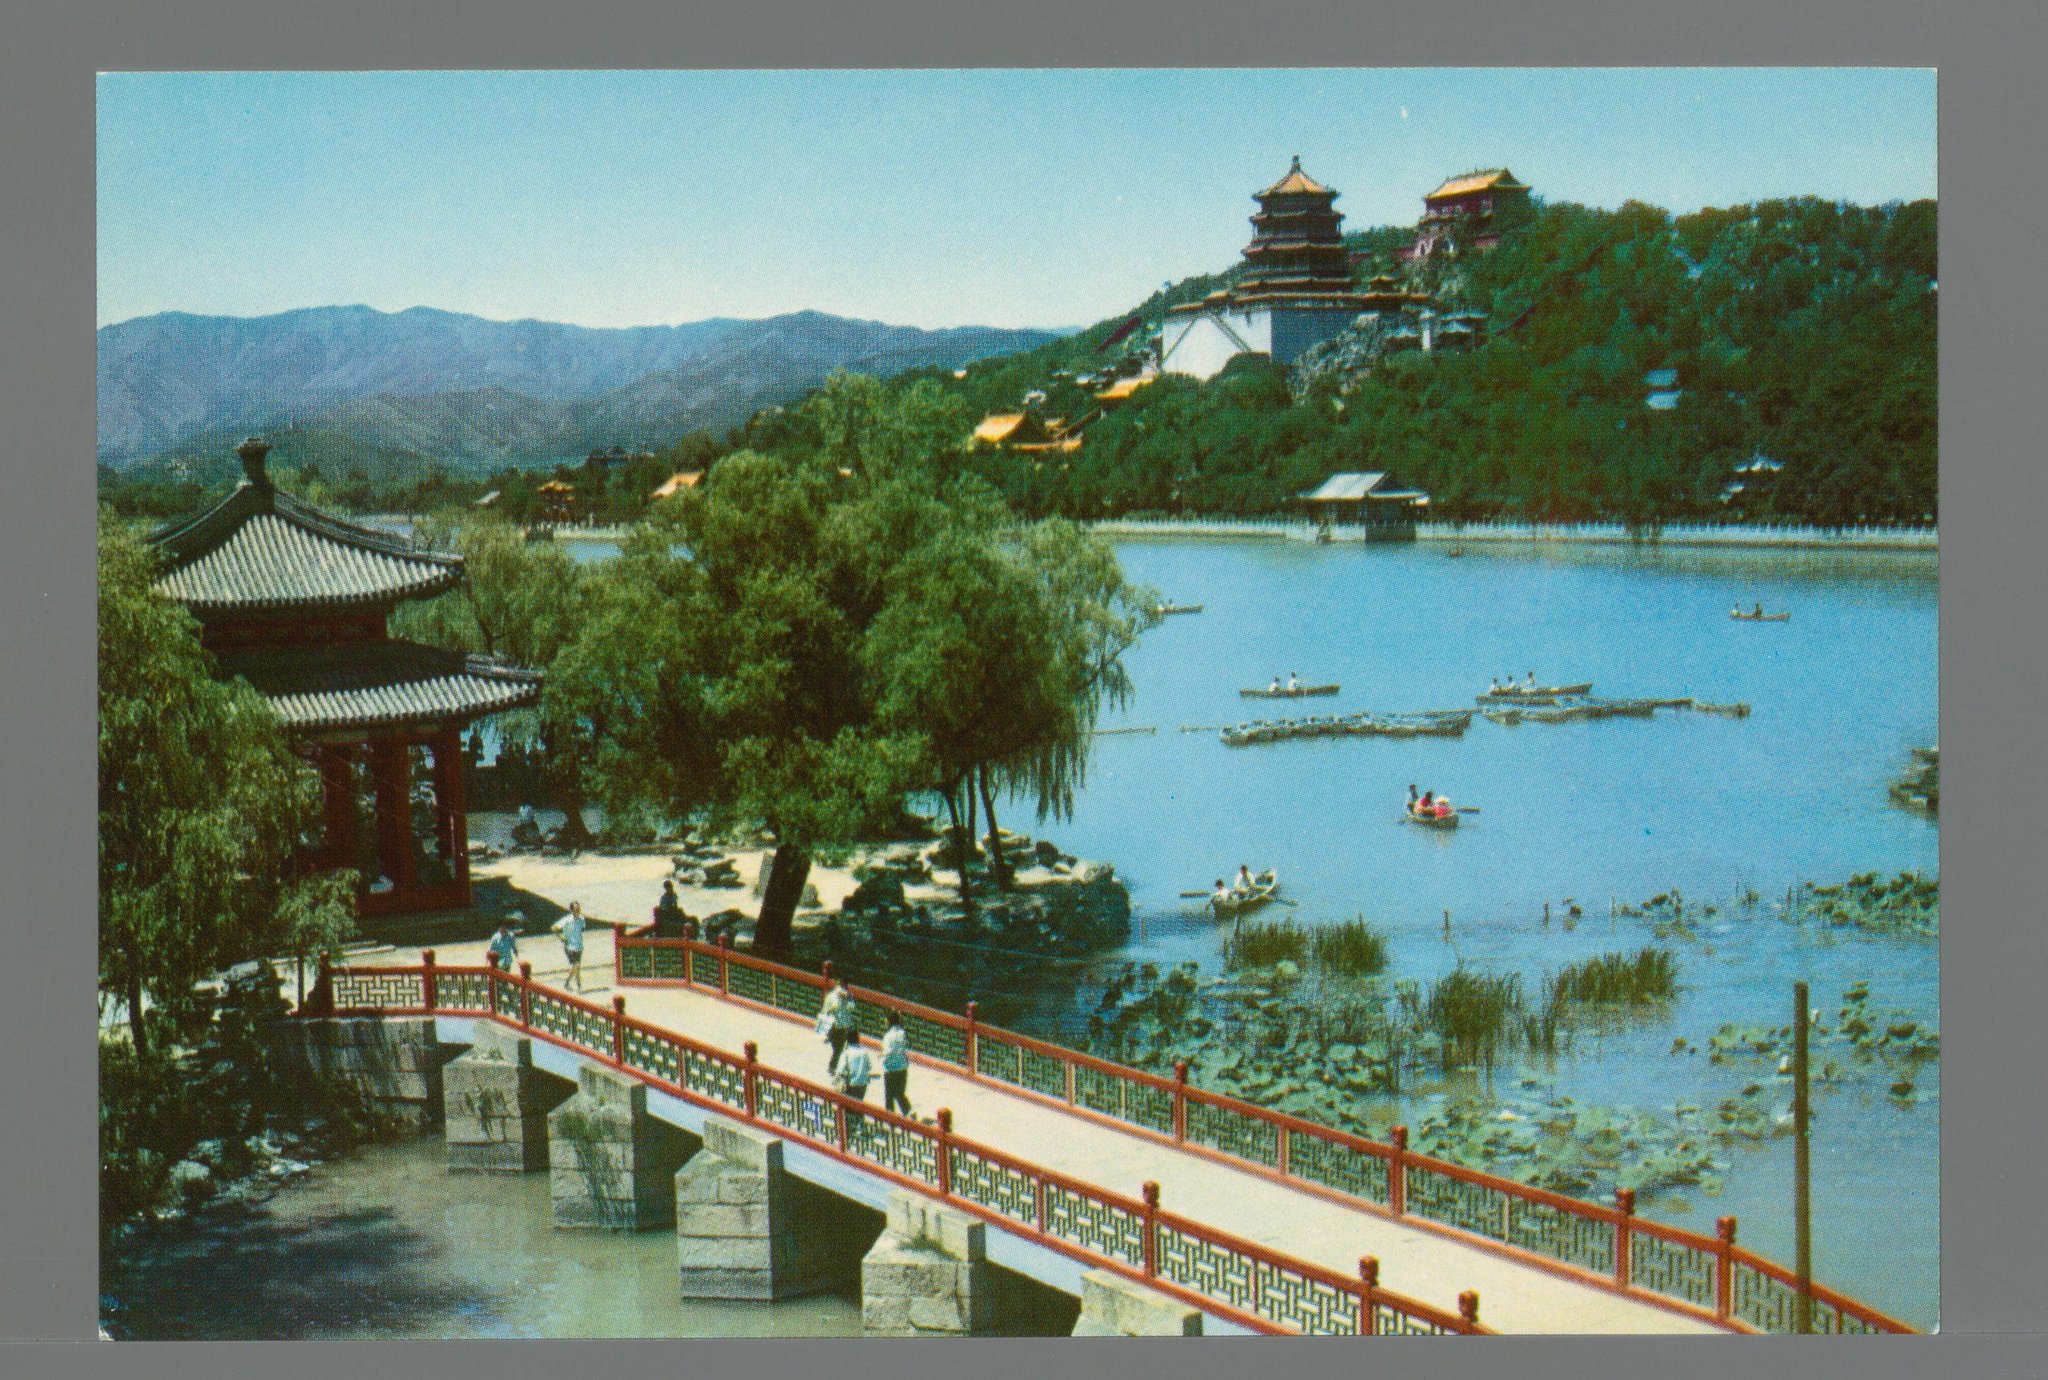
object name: ansichtkaart, prentbriefkaart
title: The Summer Palace, Peking / Vues du Palais d'Eté de Pékin / Vista del Palacio de Verano, Pekin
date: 1974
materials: cardboard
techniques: offset printed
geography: beijing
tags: palace, lake, bridge